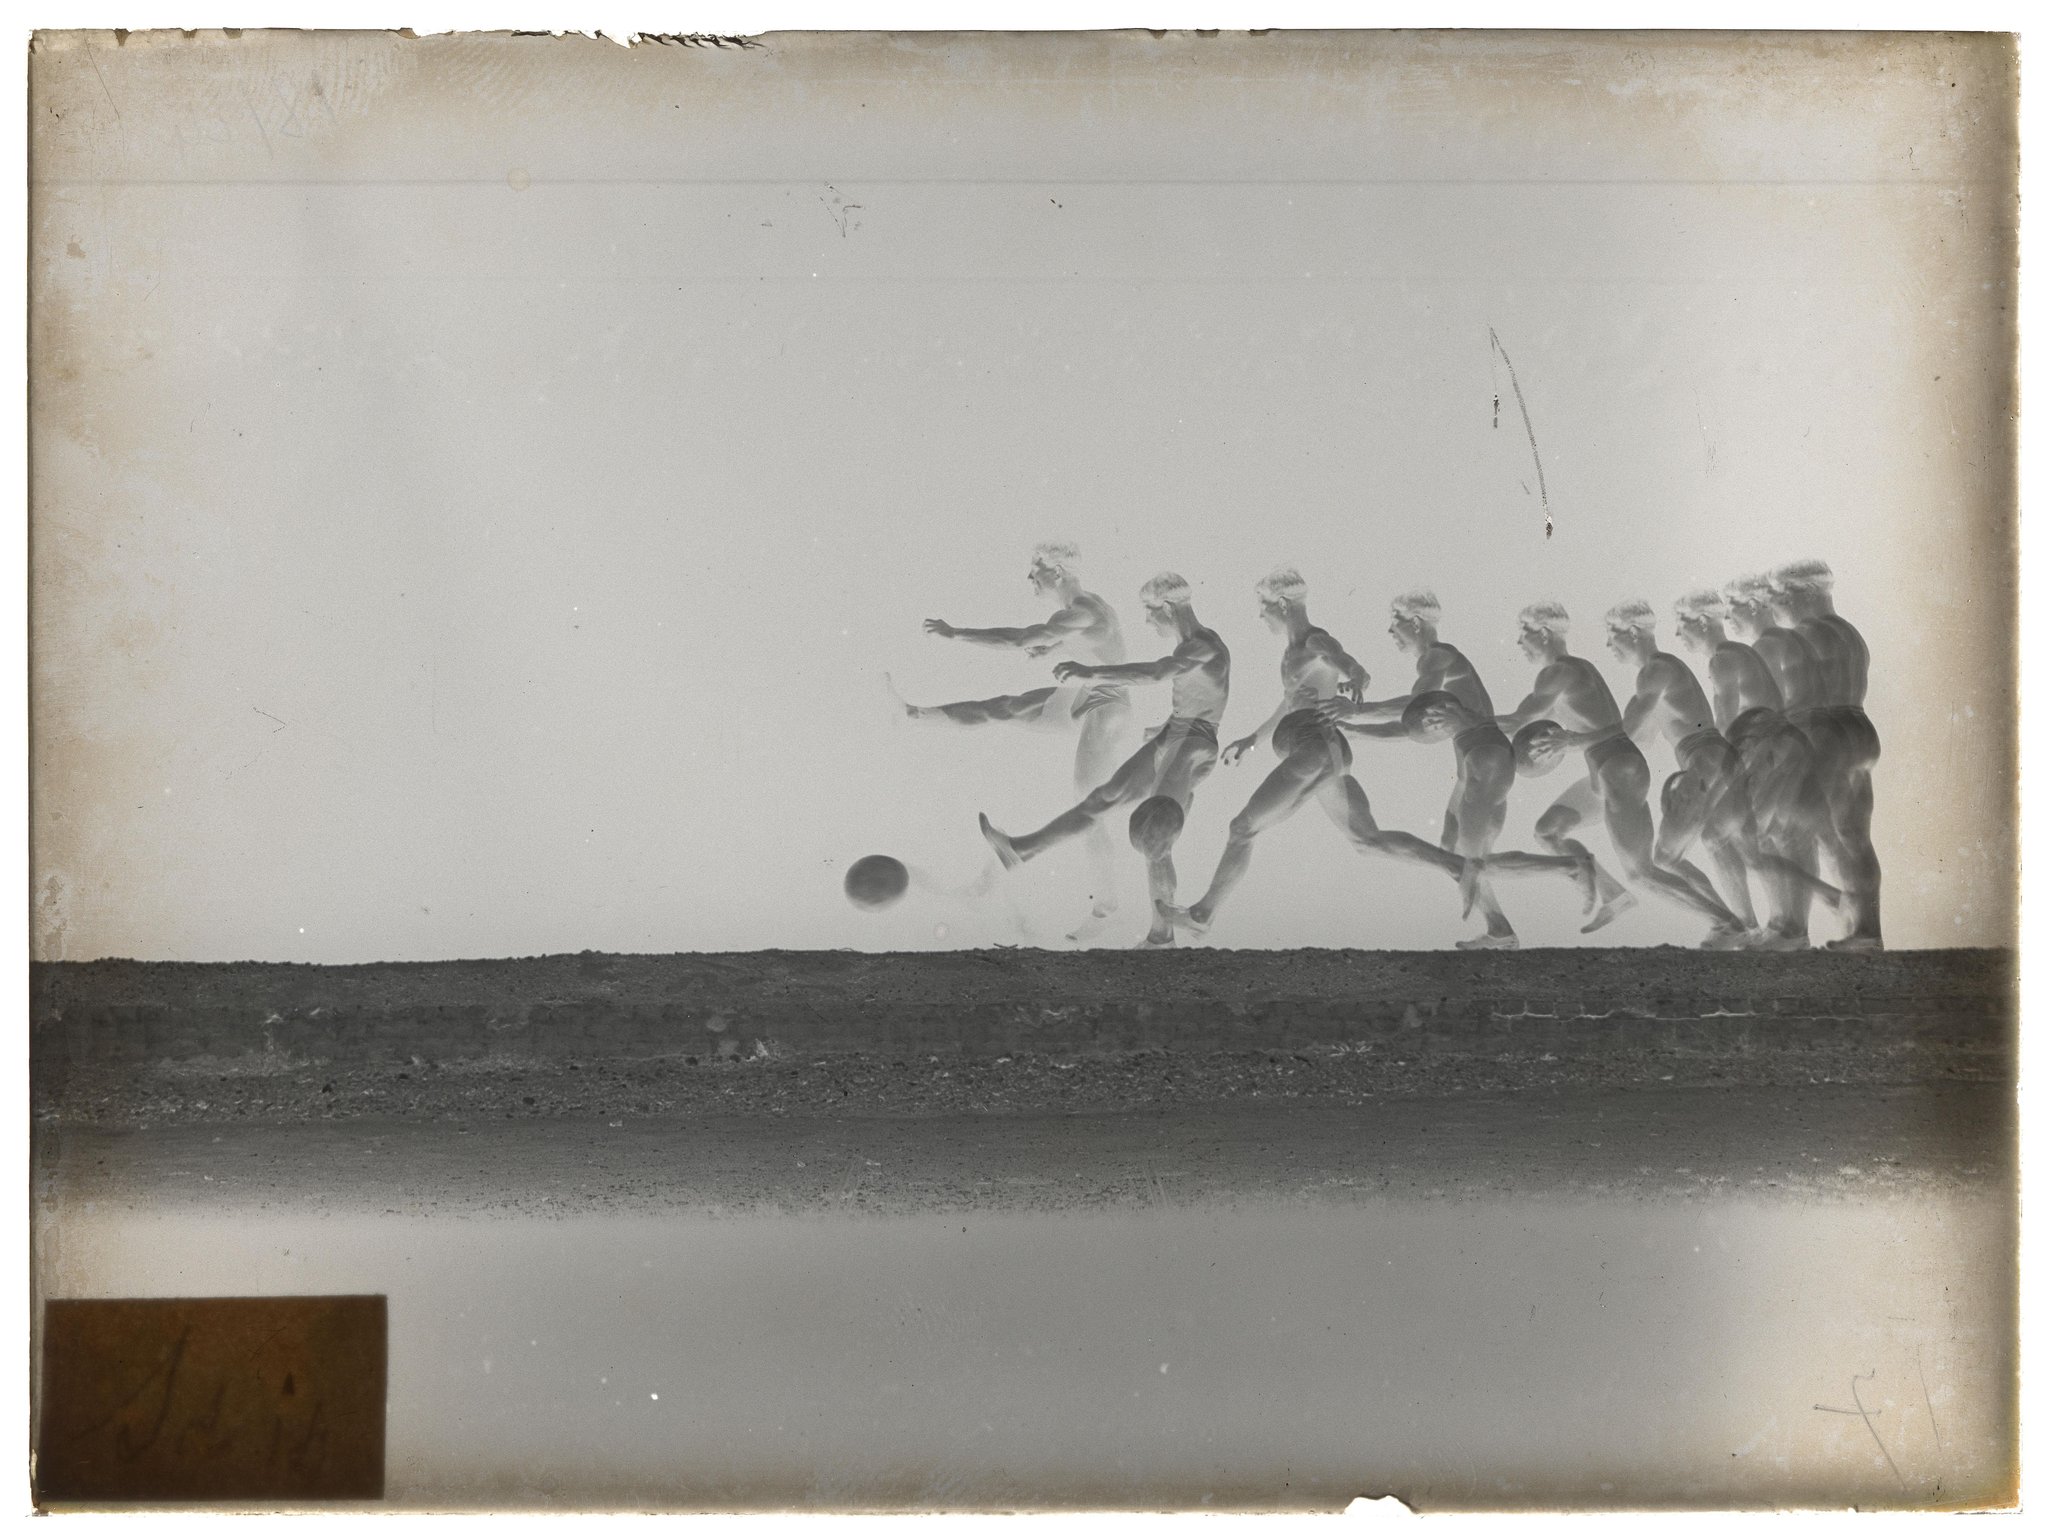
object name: glasnegatief, glasplaatnegatief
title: Footballer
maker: étienne-jules marey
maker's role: fotograaf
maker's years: 1830-1904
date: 1882-1890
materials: glass, paper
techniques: gelatin glass negative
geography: france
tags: adult man, ball games, automobile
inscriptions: inscription: ‘Id 14’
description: Bij de negatieven zijn ook de duplicaatnegatieven en moderne afdrukken die voor de boekpublicatie vervaardigd zijn.